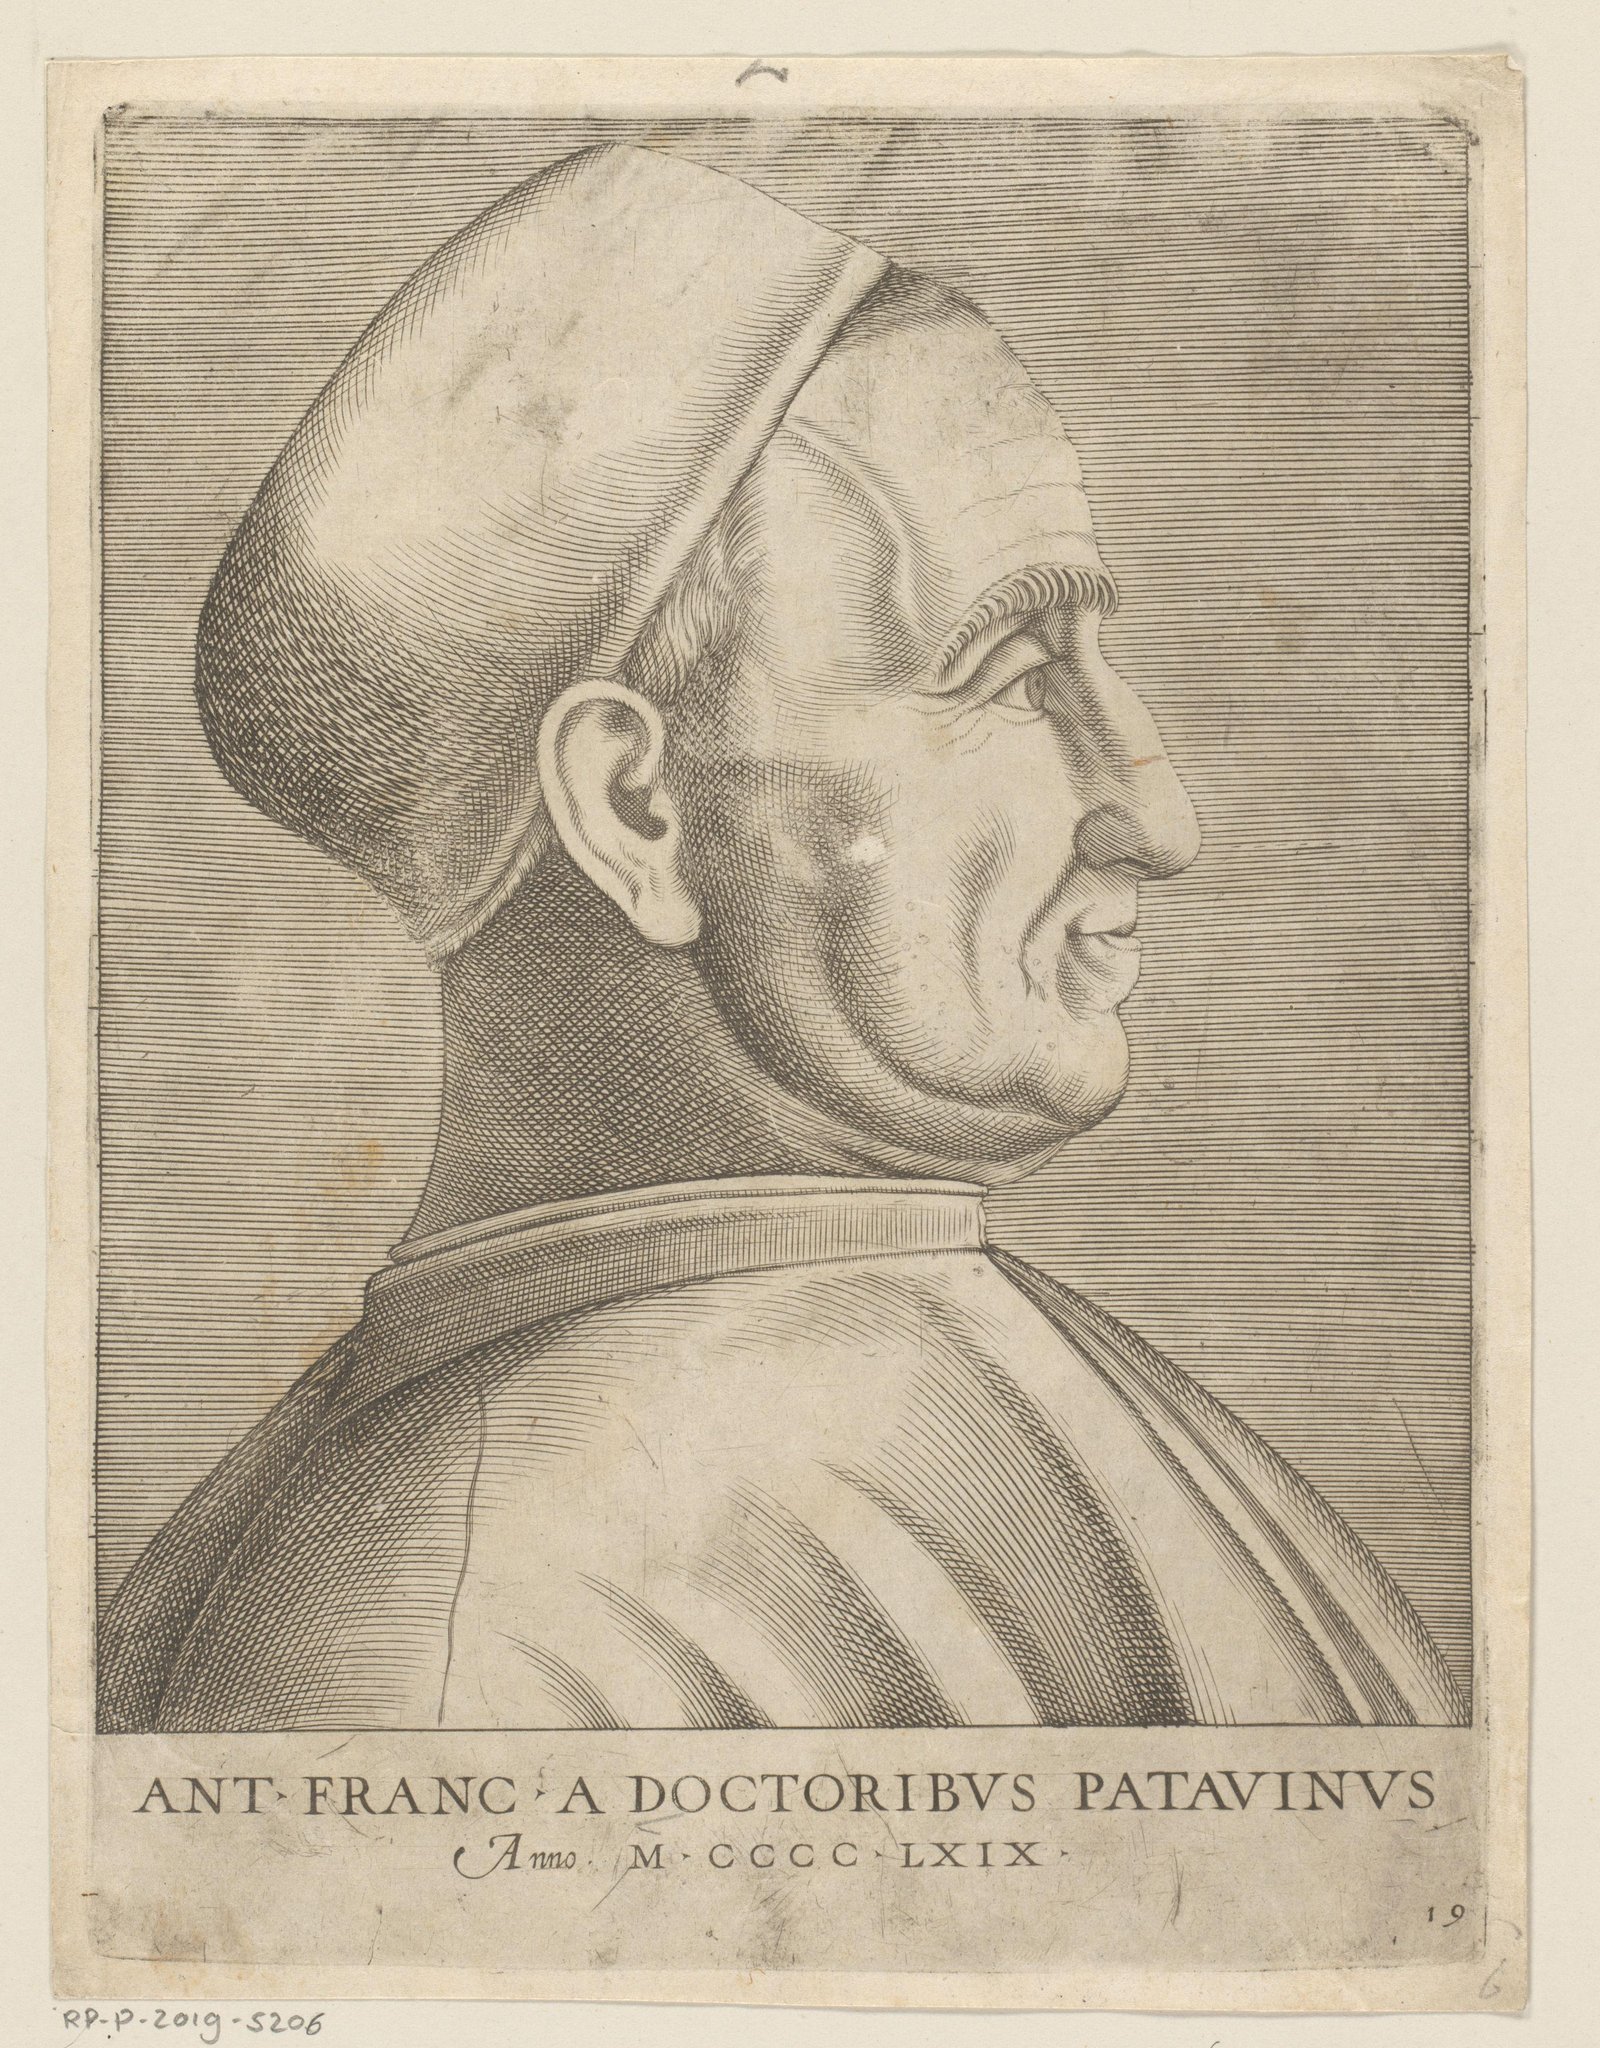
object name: print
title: Illustrium jureconsultorum imagines quae inveniri potuerunt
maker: Anonymous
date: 1566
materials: paper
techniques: engraving, intaglio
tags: historical persons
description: Prentserie voor het eerst uitgegeven te Rome door Antonio Lafreri in 1566. Serie waarschijnlijk opnieuw uitgegeven door Petri de' Nobili rond 1584-1585.